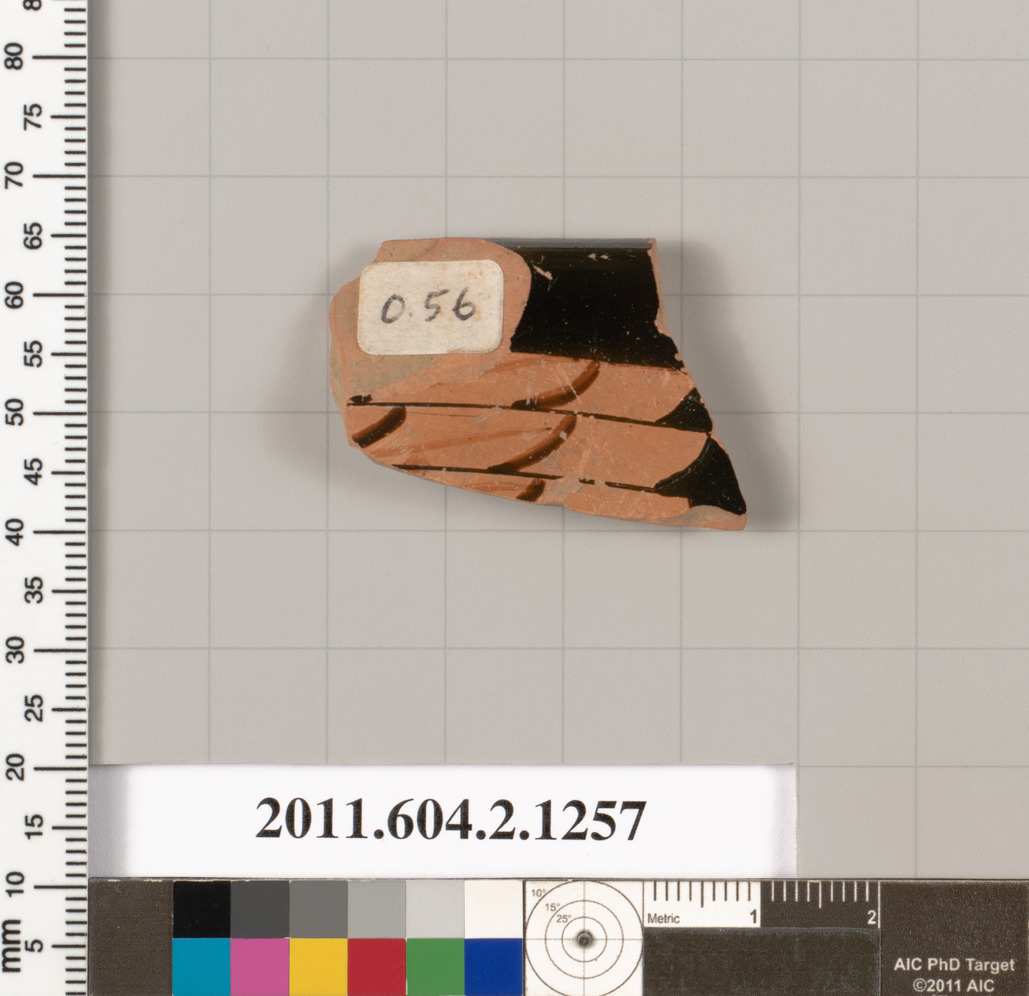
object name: skyphos fragment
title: Terracotta rim fragment of a skyphos (deep drinking cup)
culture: greek, attic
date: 475-451 BCE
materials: terracotta